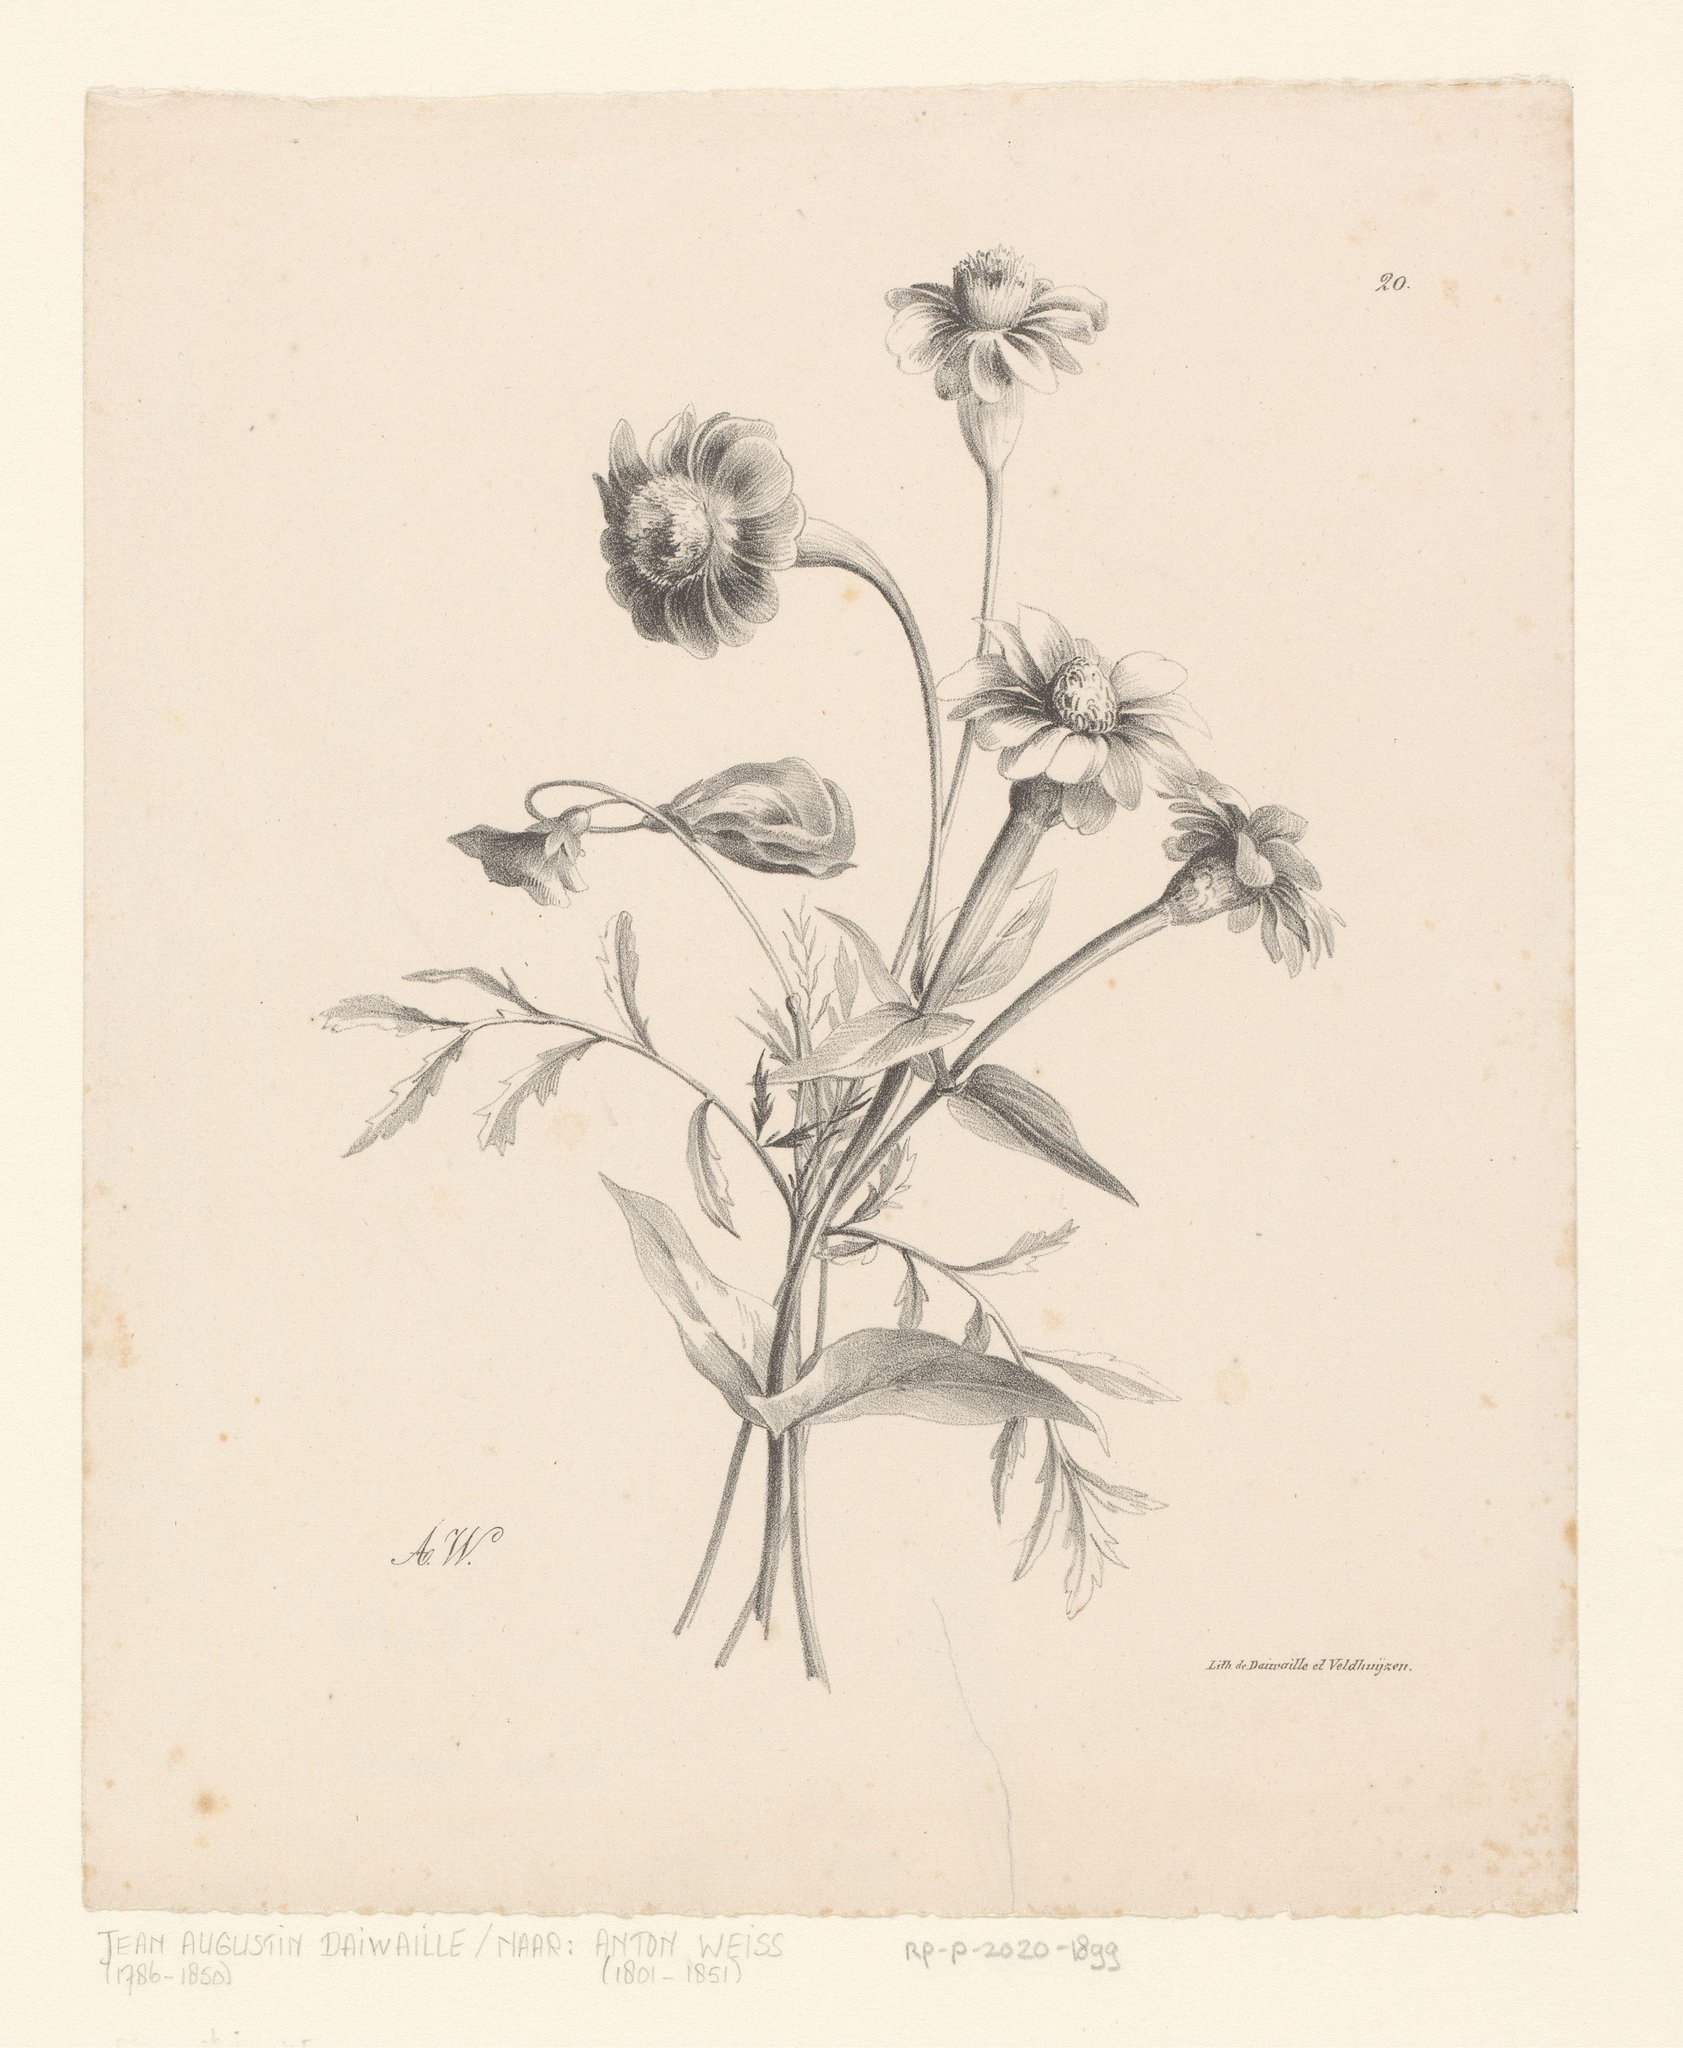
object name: print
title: Diverse bloemen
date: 1831-1835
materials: paper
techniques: lithograph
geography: netherlands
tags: flowers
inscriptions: collector's mark: Lugt 2228